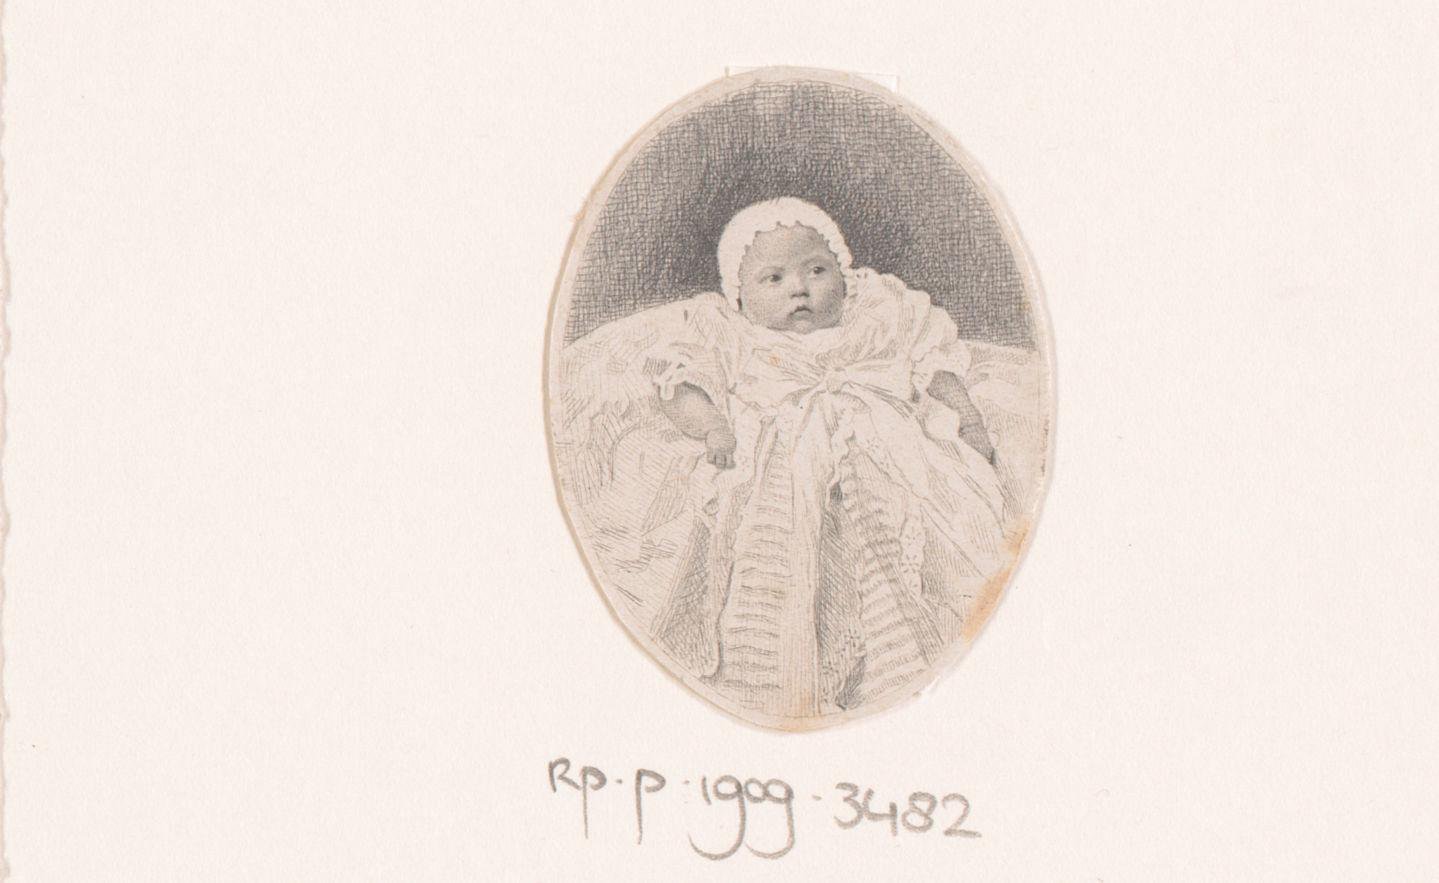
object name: print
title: Portret van Marie Danse als baby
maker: auguste danse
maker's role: print maker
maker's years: 1829-1929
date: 1868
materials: paper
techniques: etching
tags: marie danse, female infant, infant, baby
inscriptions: collector's mark: Lugt 2228